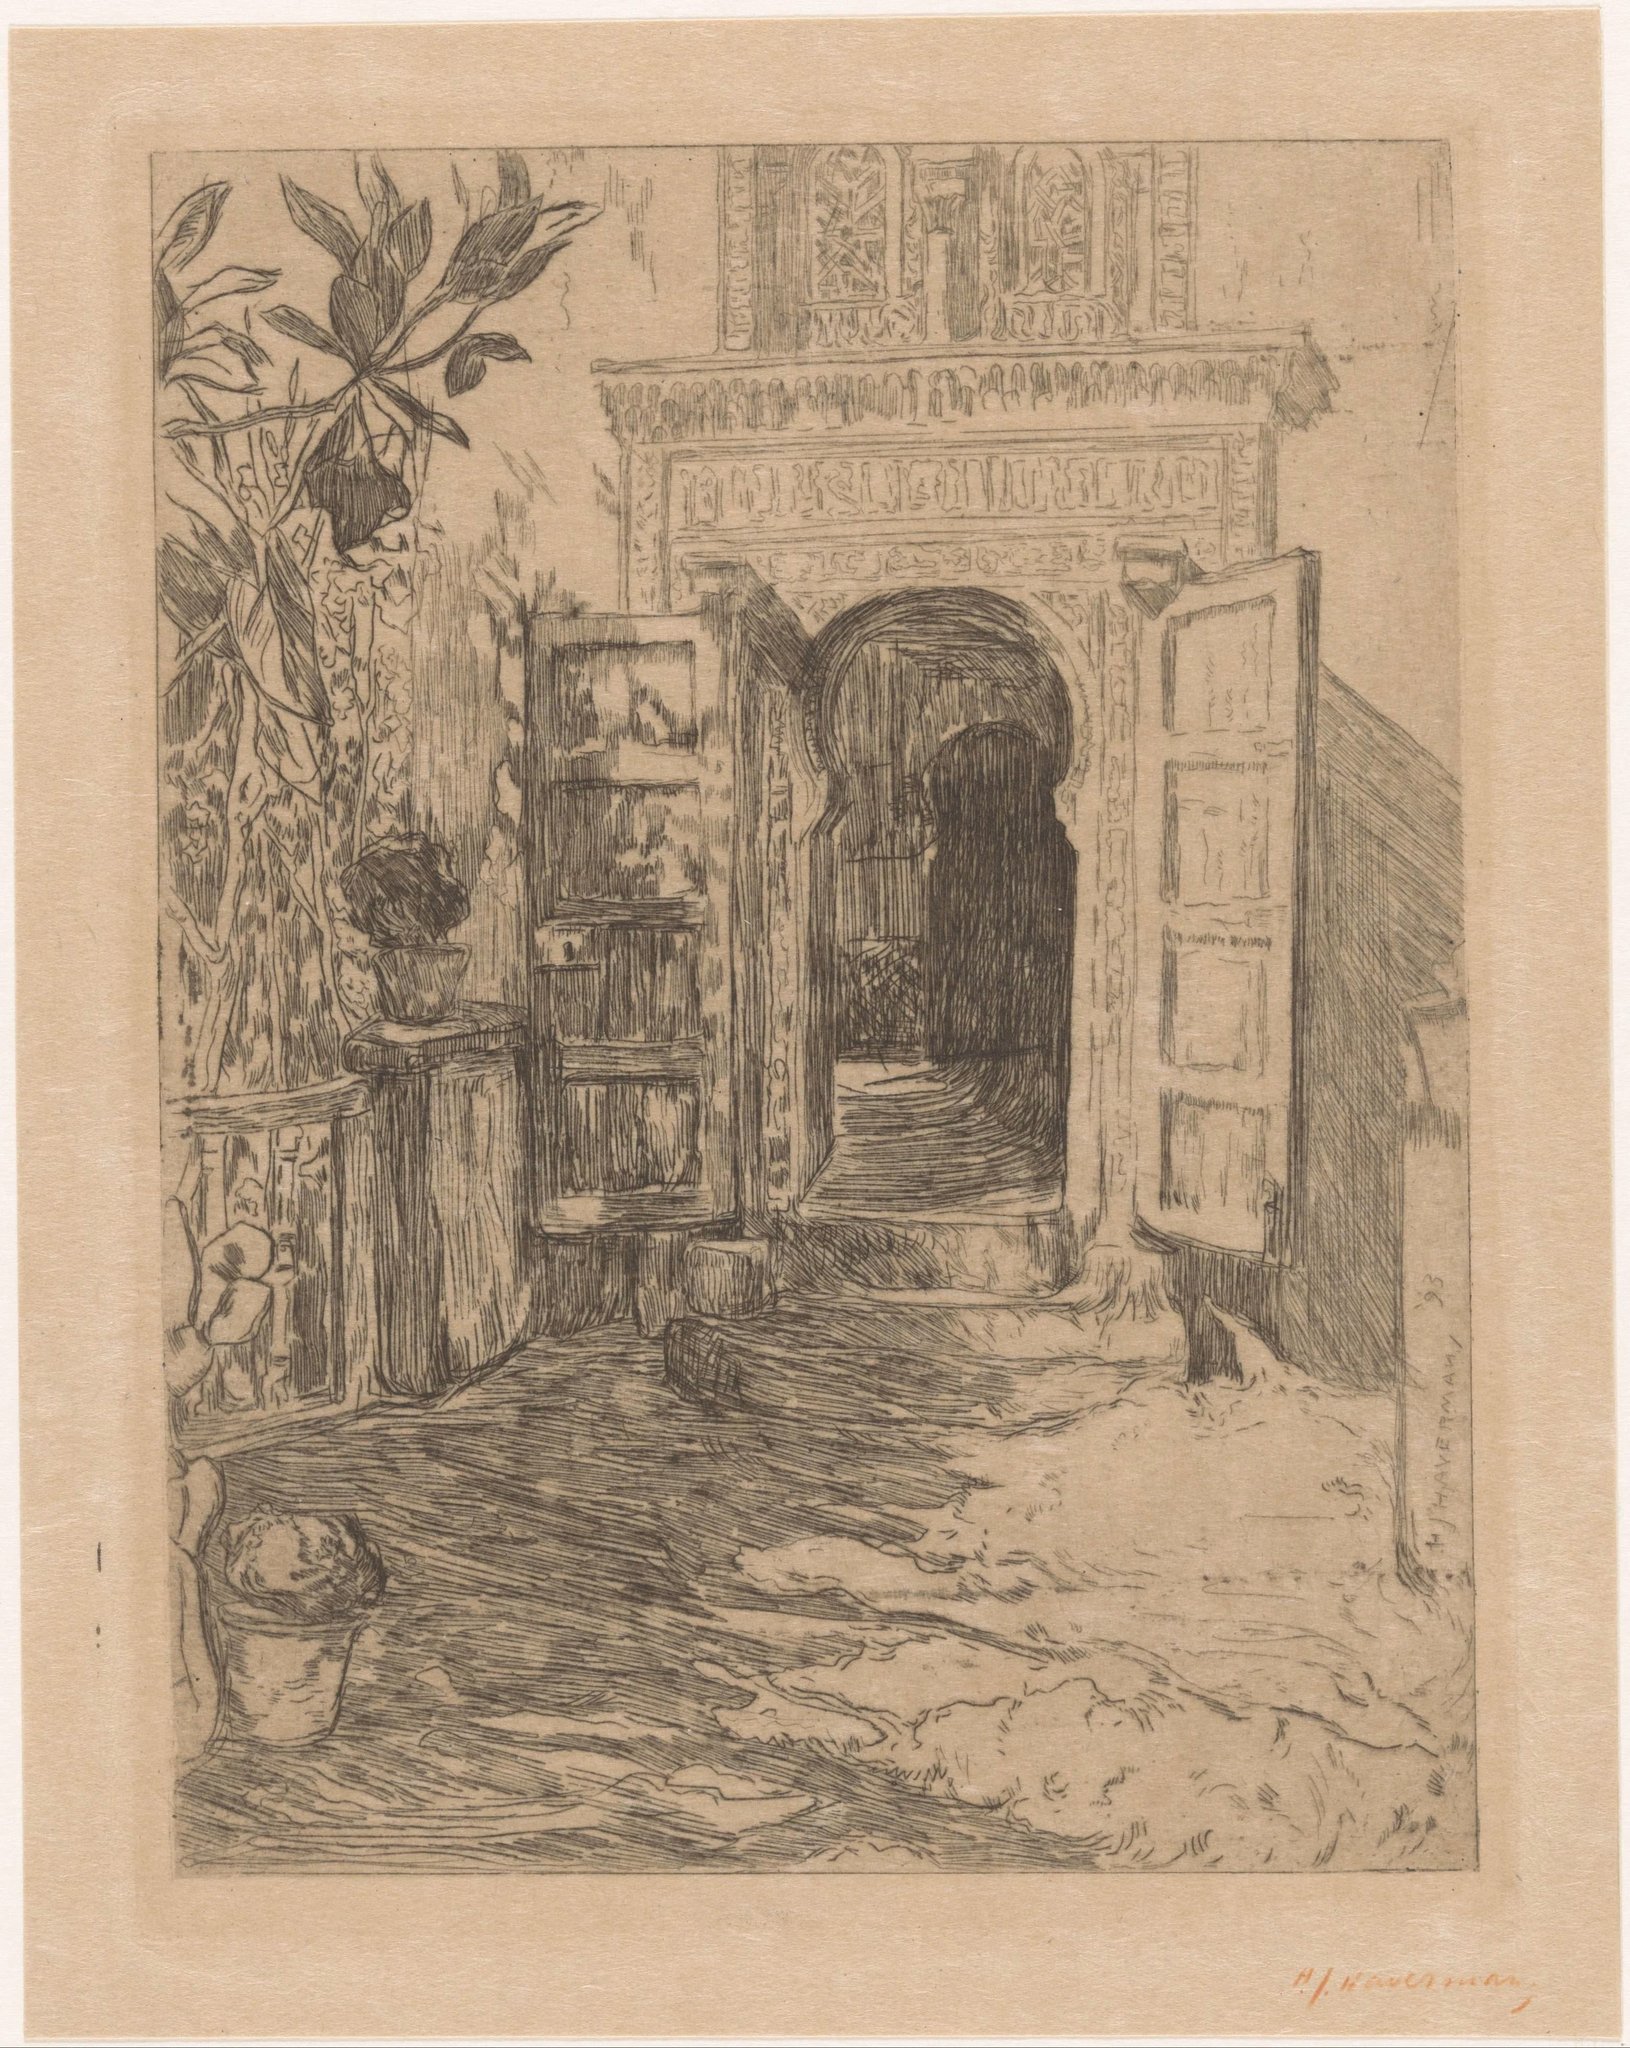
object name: print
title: Ingang van de Oratorio del Partal in het Alhambra te Granada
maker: hendrik johannes haverman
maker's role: draughtsman, print maker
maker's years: 1857-1928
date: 1867-1928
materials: paper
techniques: etching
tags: gate, entrance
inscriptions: collector's mark: Lugt 2228